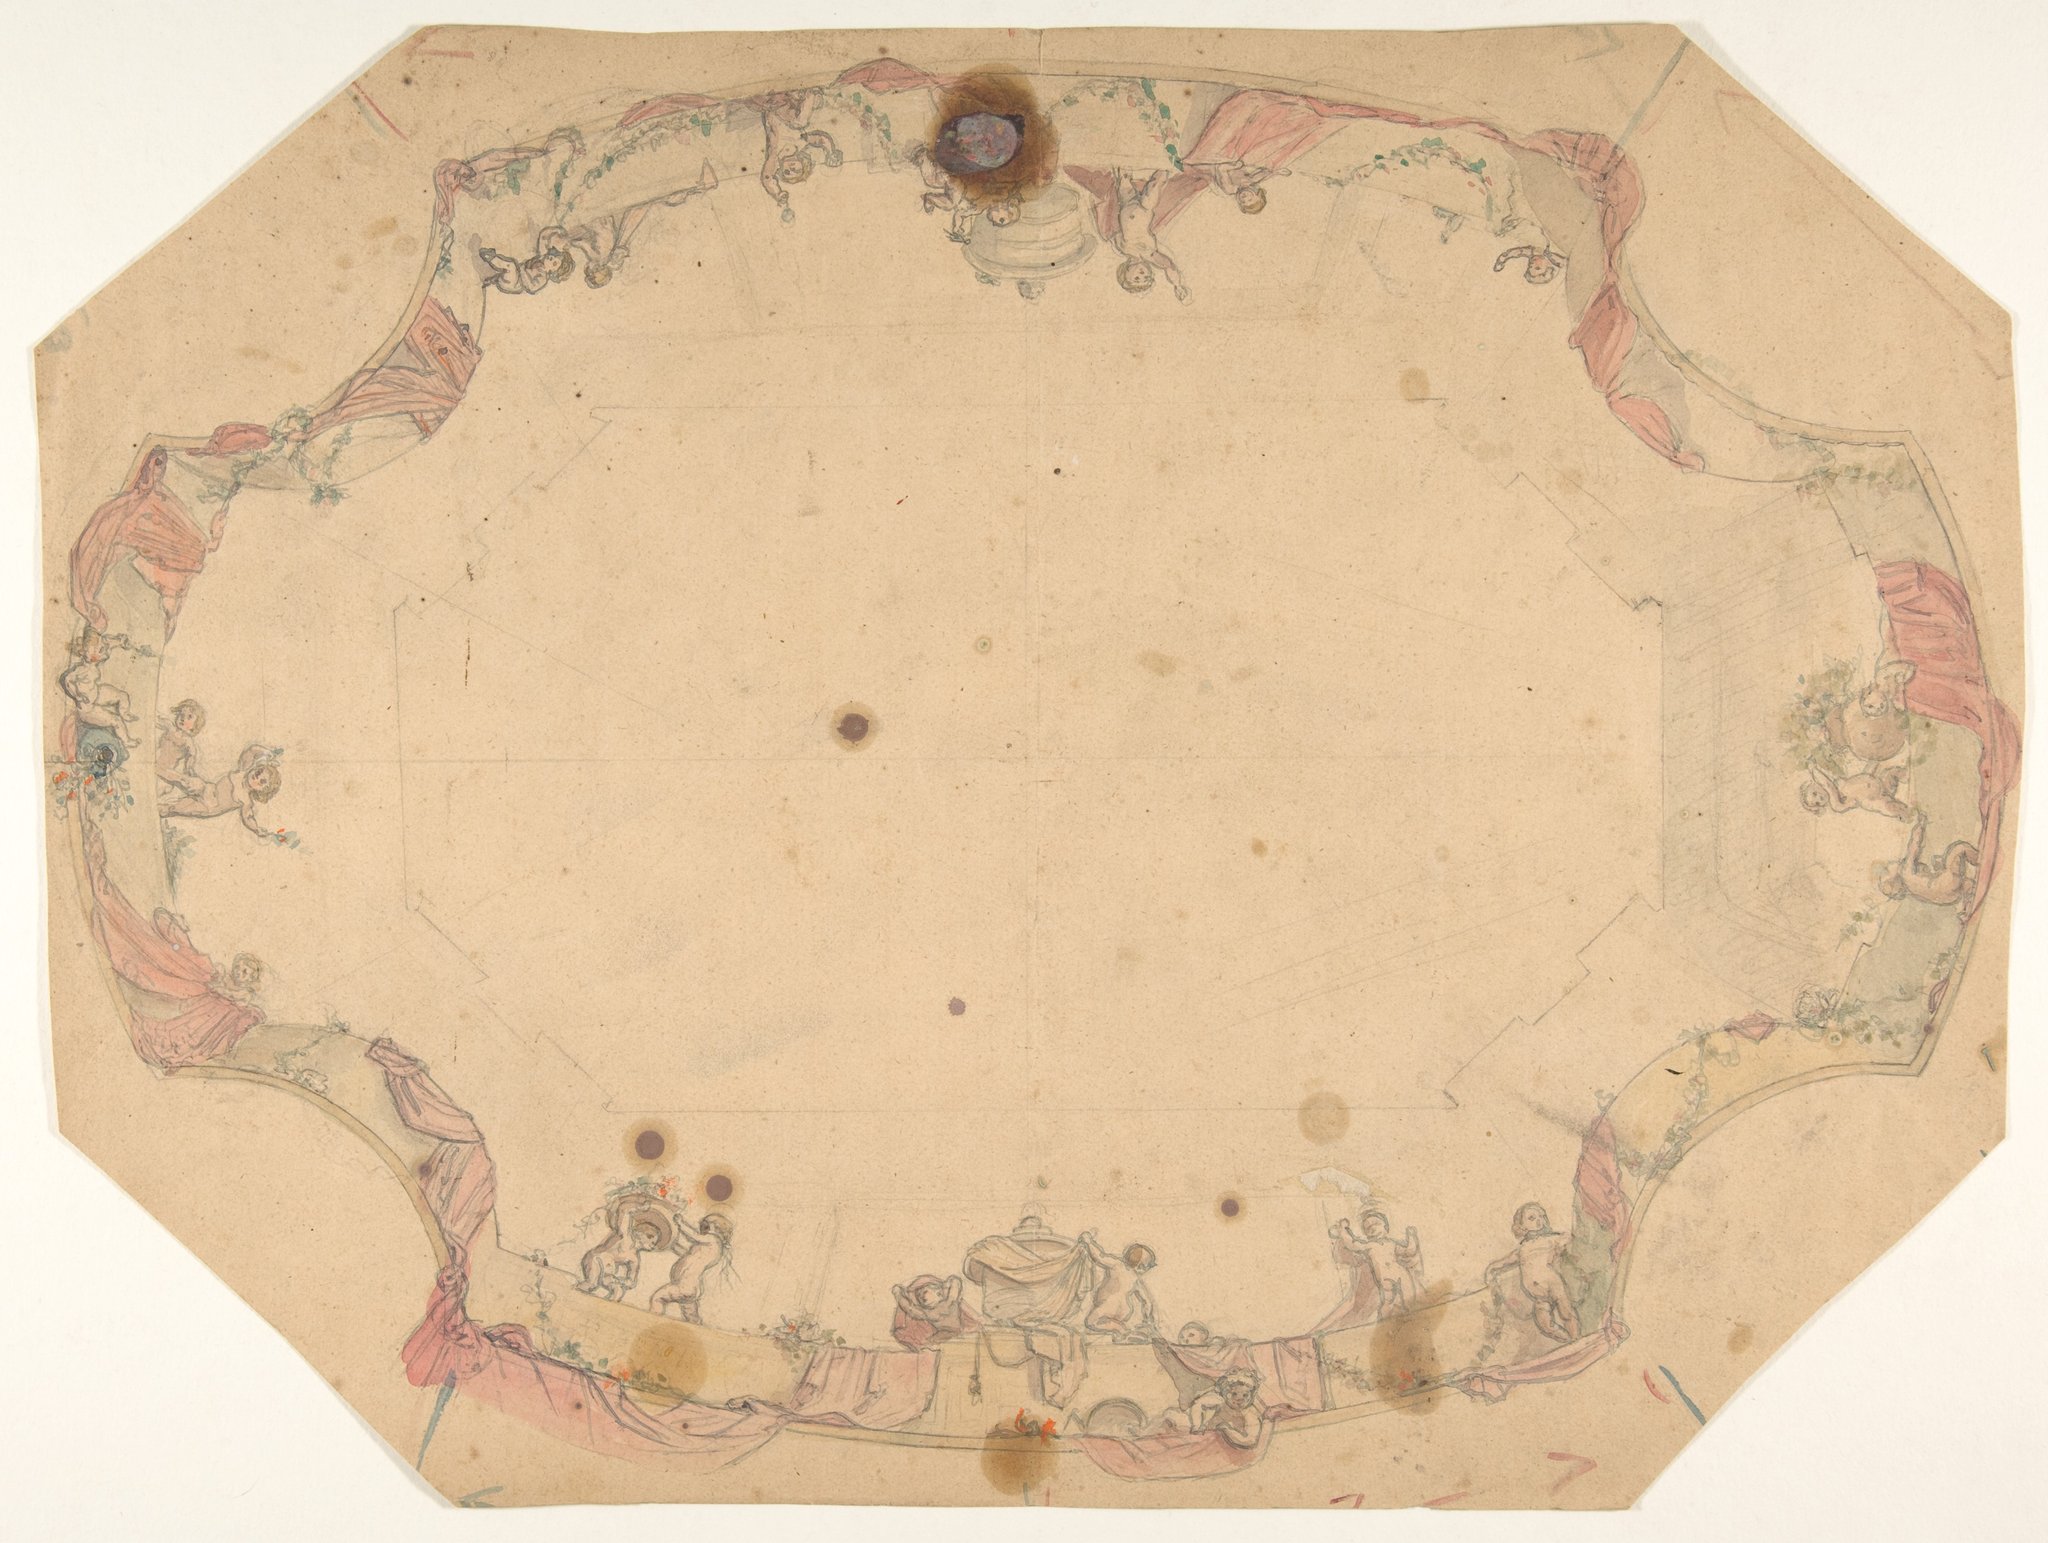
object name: drawing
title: Design for a ceiling painted with putti, garlands, and swags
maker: jules-edmond-charles lachaise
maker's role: artist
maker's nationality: french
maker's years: 1897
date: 1851-1900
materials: graphite, watercolor, paper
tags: putti,ceilings